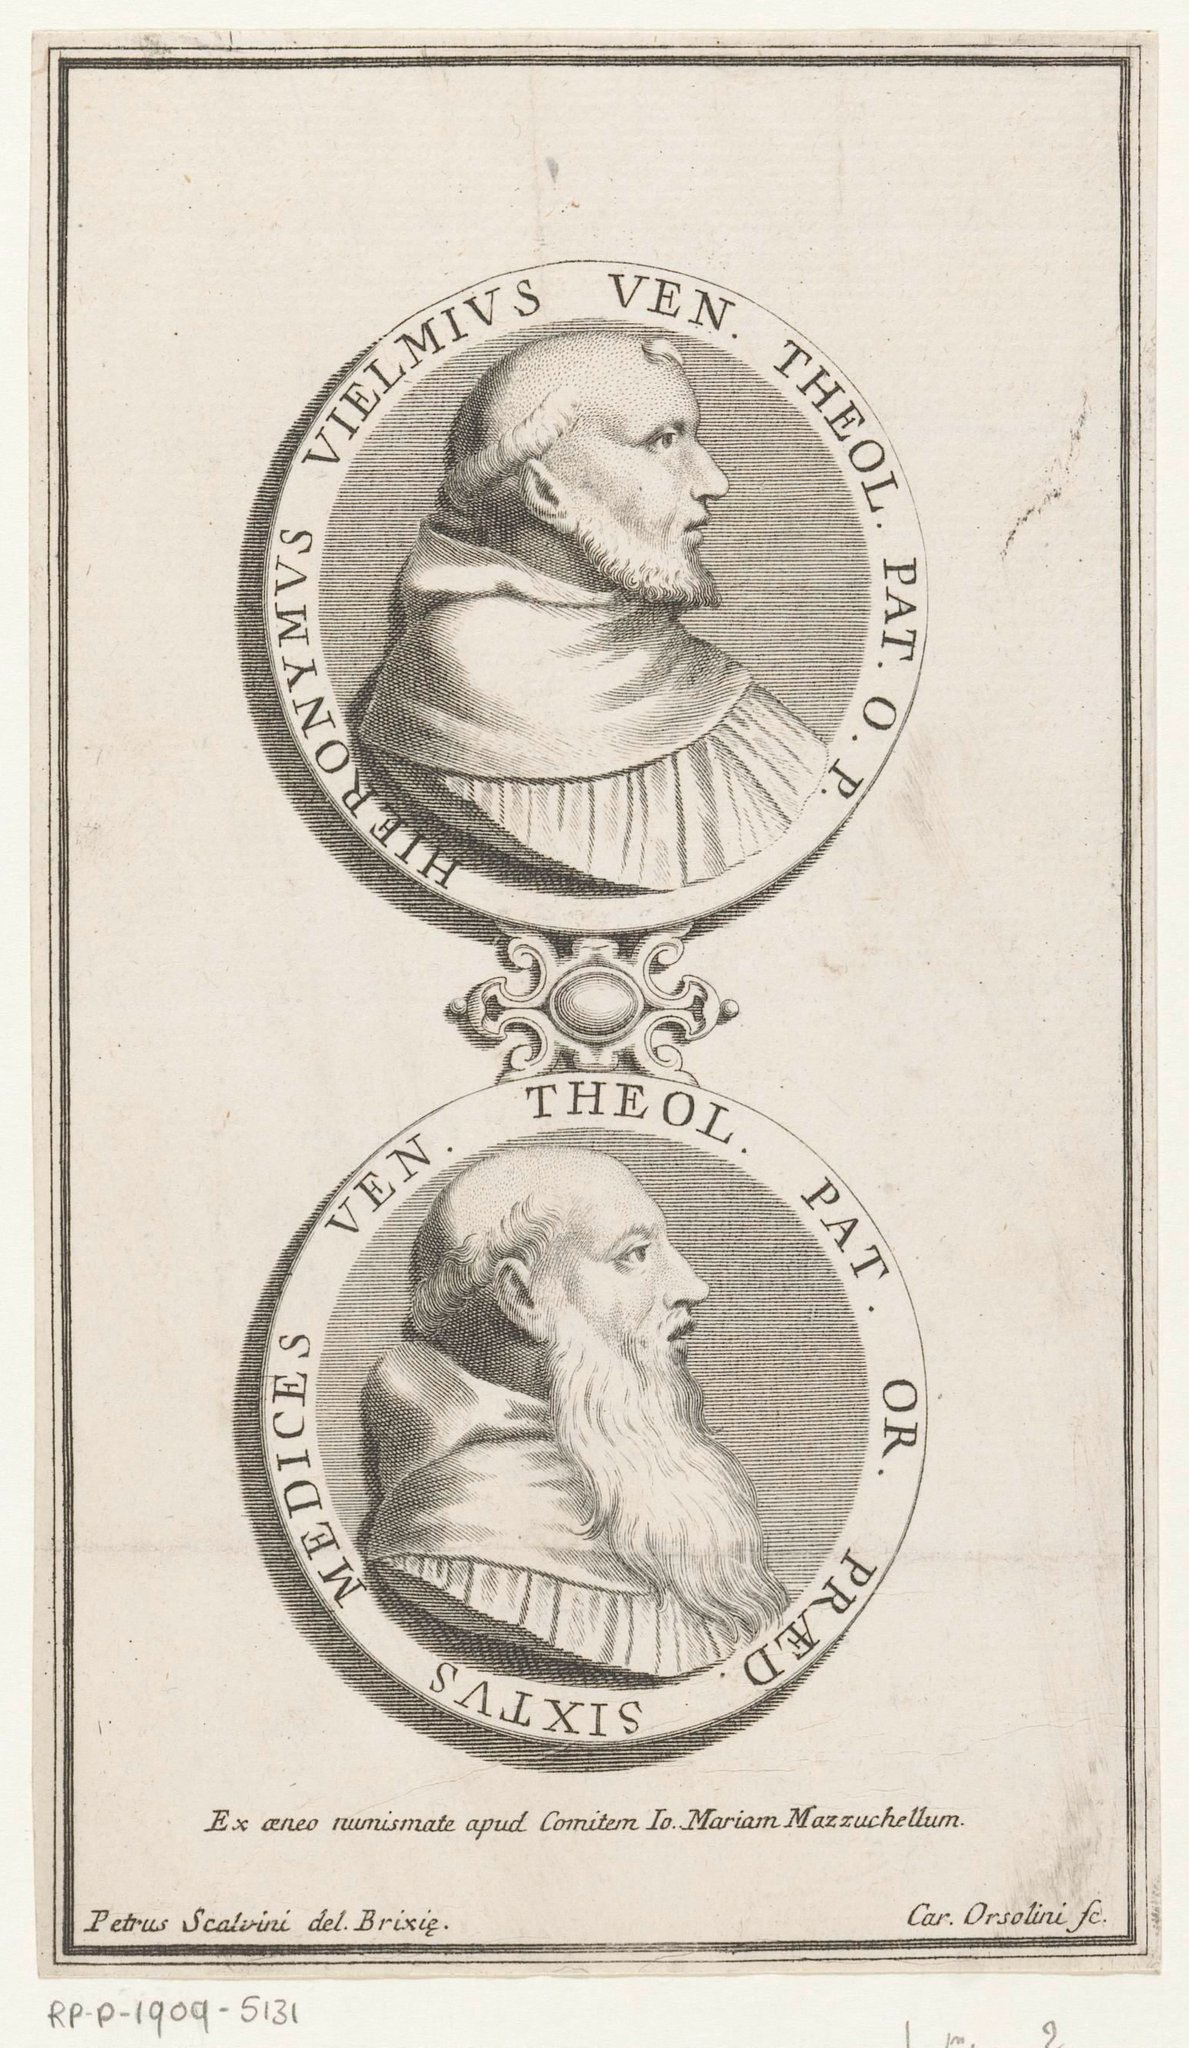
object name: print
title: Twee penningen met portretten van bisschop Girolamo Vielmi en dominicaan Sixtus Medices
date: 1720-1780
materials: paper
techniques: engraving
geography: bressanone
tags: venice, archbishop, bishop, etc. (roman catholic), historical persons, monastic orders, monastic life: dominicans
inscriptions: collector's mark: Lugt 2228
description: Volgens de Latijnse tekst onder de portretten bevonden de bronzen penningen zich in de collectie van graaf Giammaria Mazzucchelli.